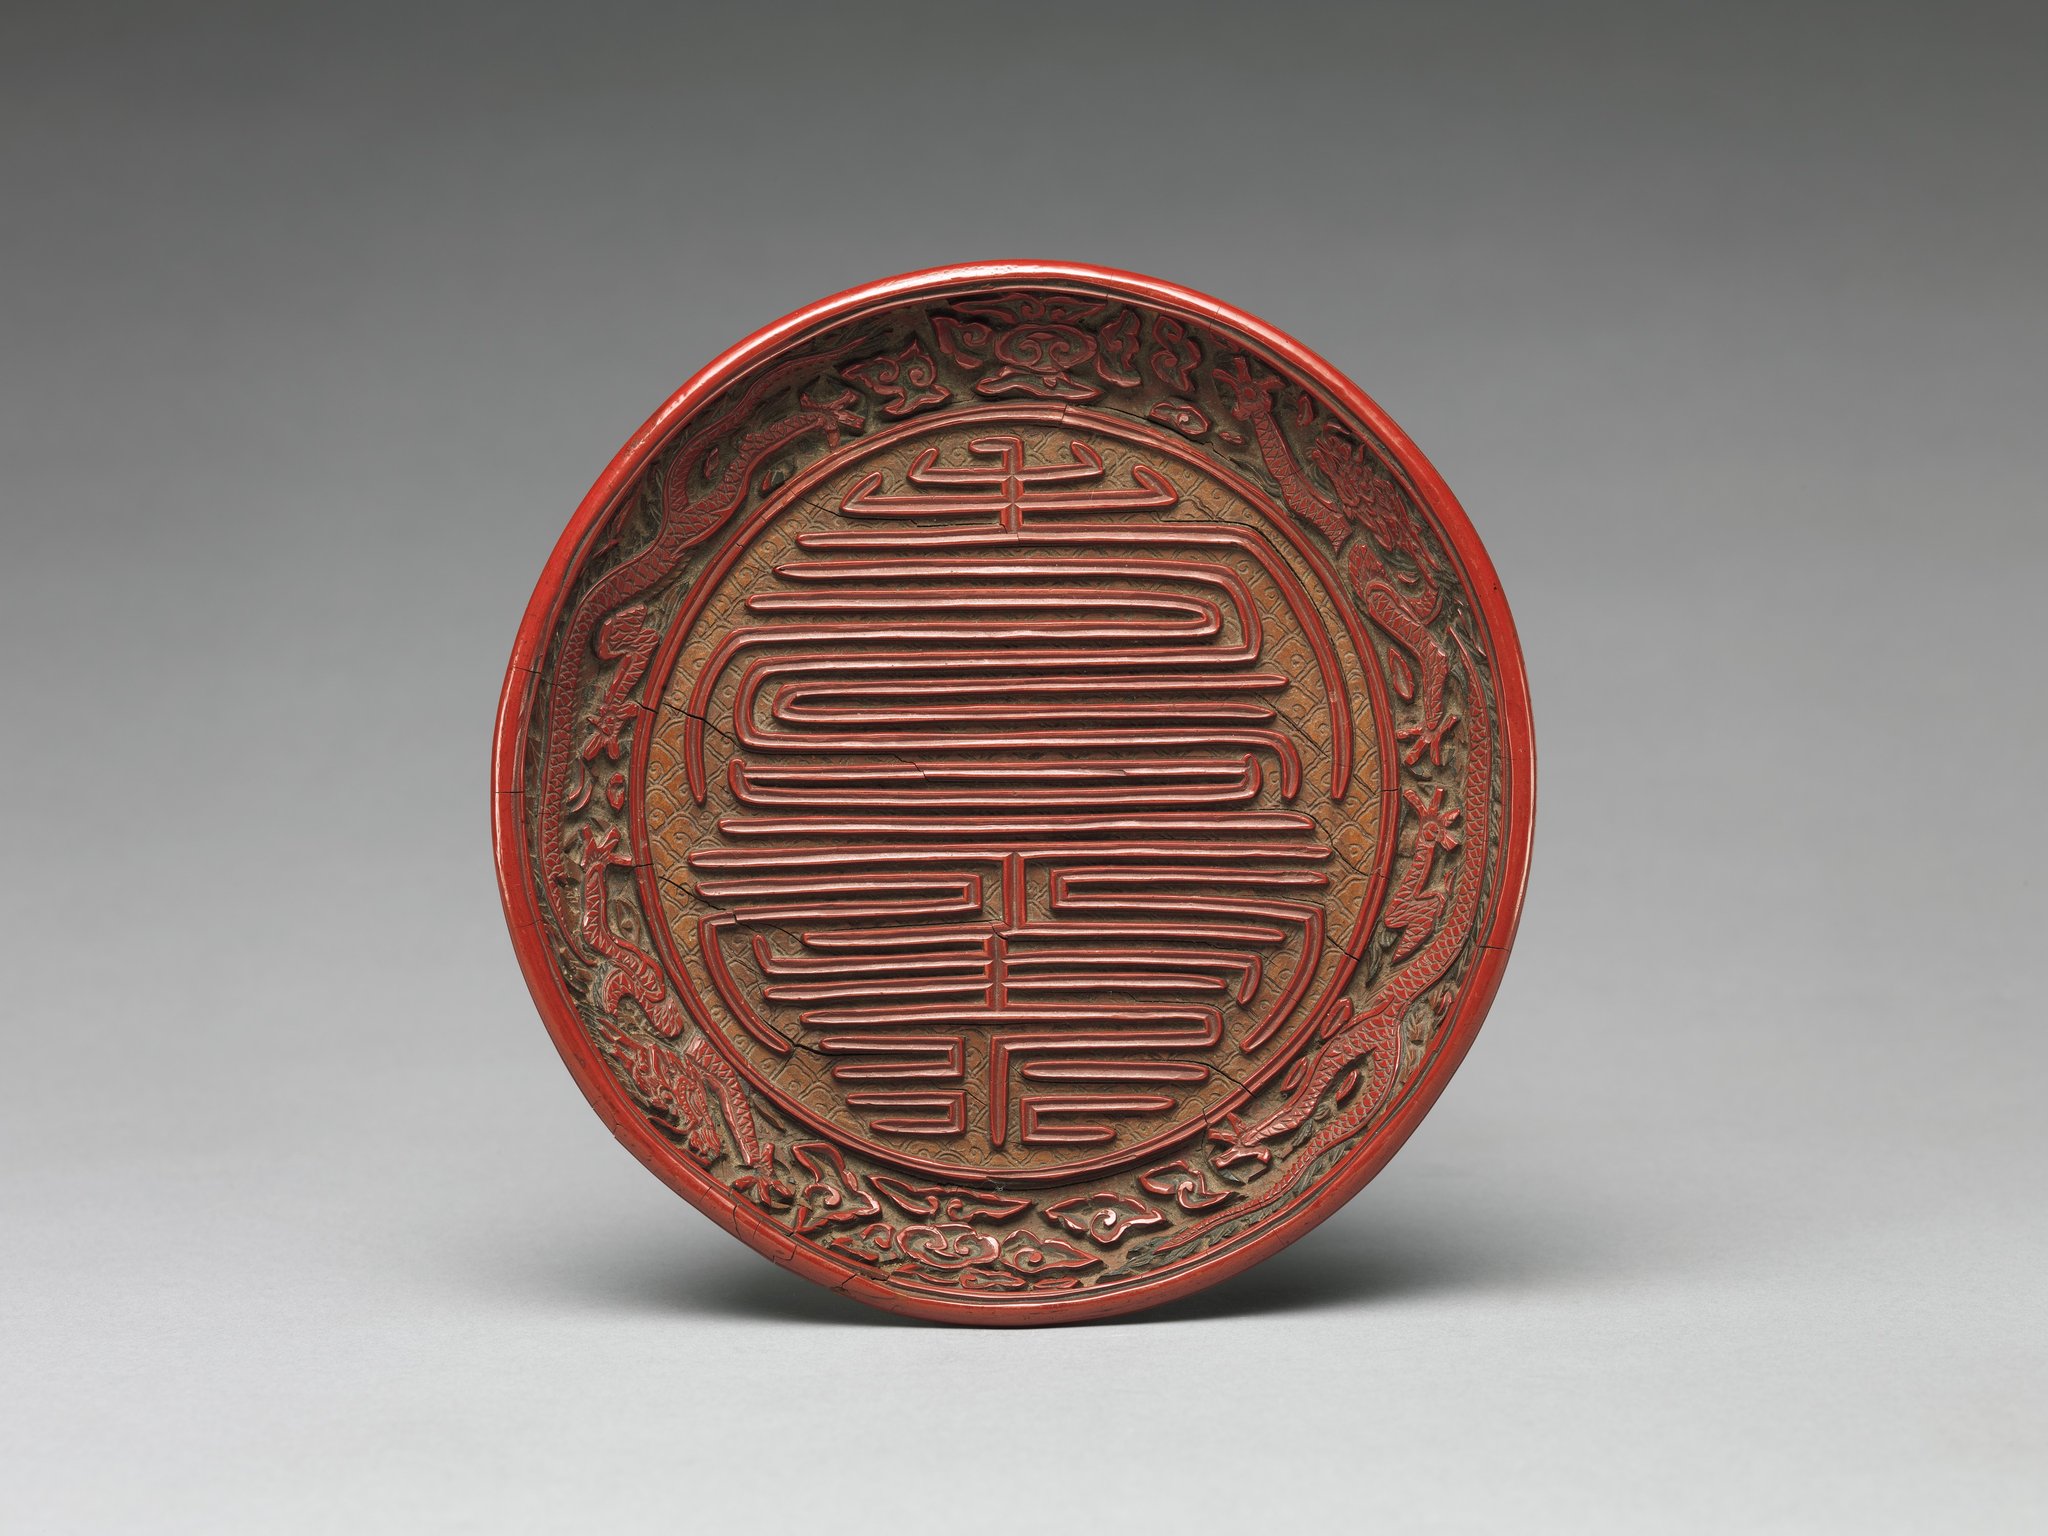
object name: dish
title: Dish with characters for longevity and health (shou kang)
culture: chinese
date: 1534-1566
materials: lacquer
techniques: carving